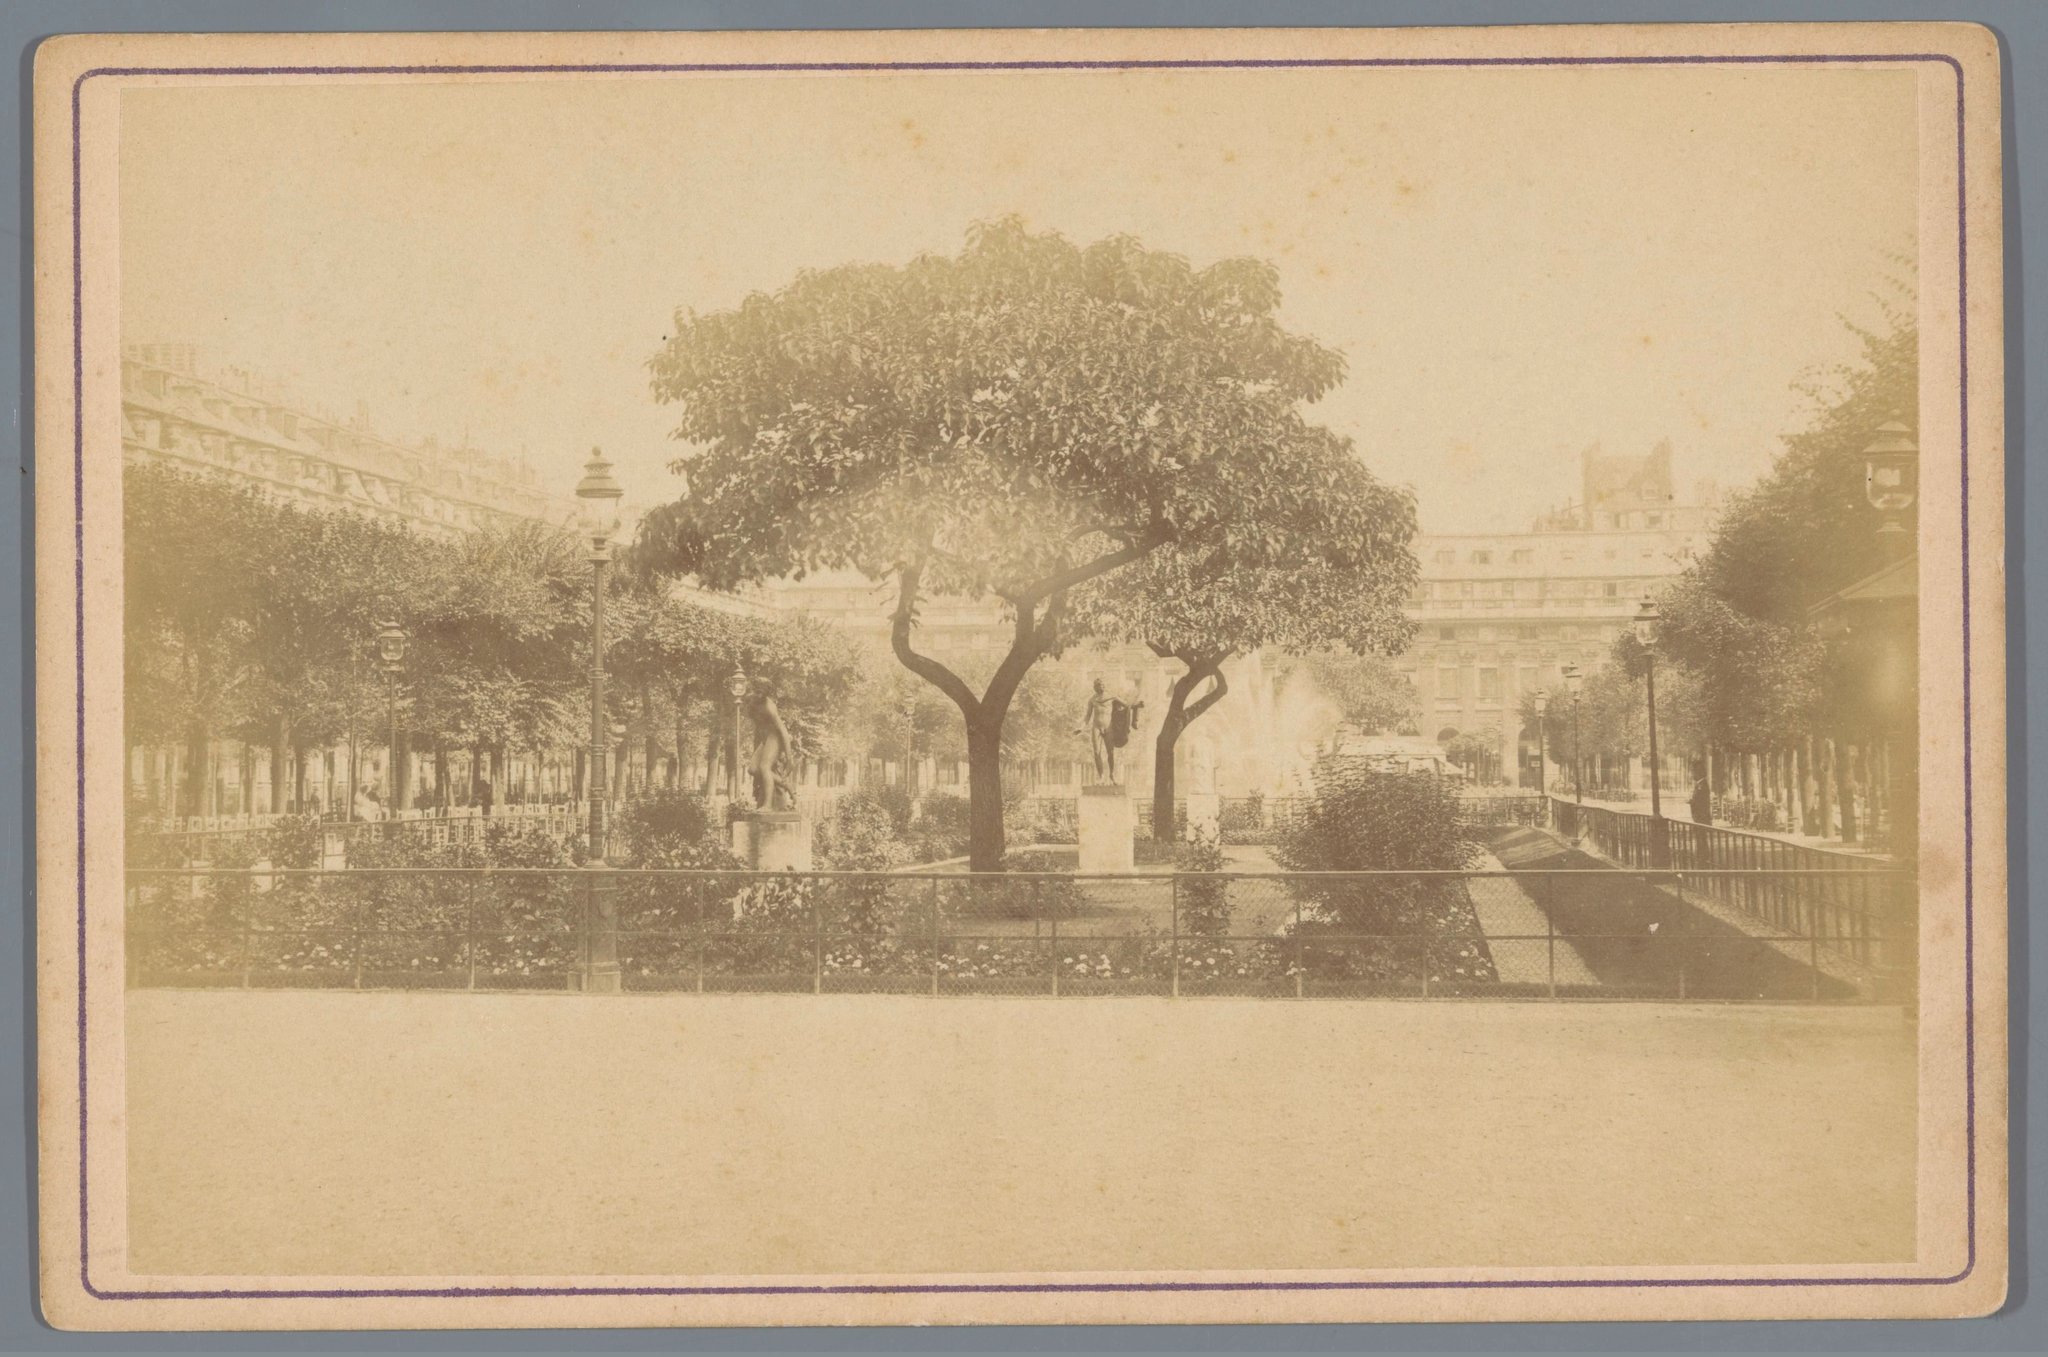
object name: cabinet photograph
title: Tuin van het Palais-Royal te Parijs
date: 1865-1875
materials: cardboard, paper, photographic support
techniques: albumen print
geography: jardin du palais royal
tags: french or architectonic garden; formal garden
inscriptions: inscription: ‘Jardin du Palais Royal’, signature and date: ‘Compagnie Photographique / Debitte & Hervé / 170, Rue de Rivoli, Paris’